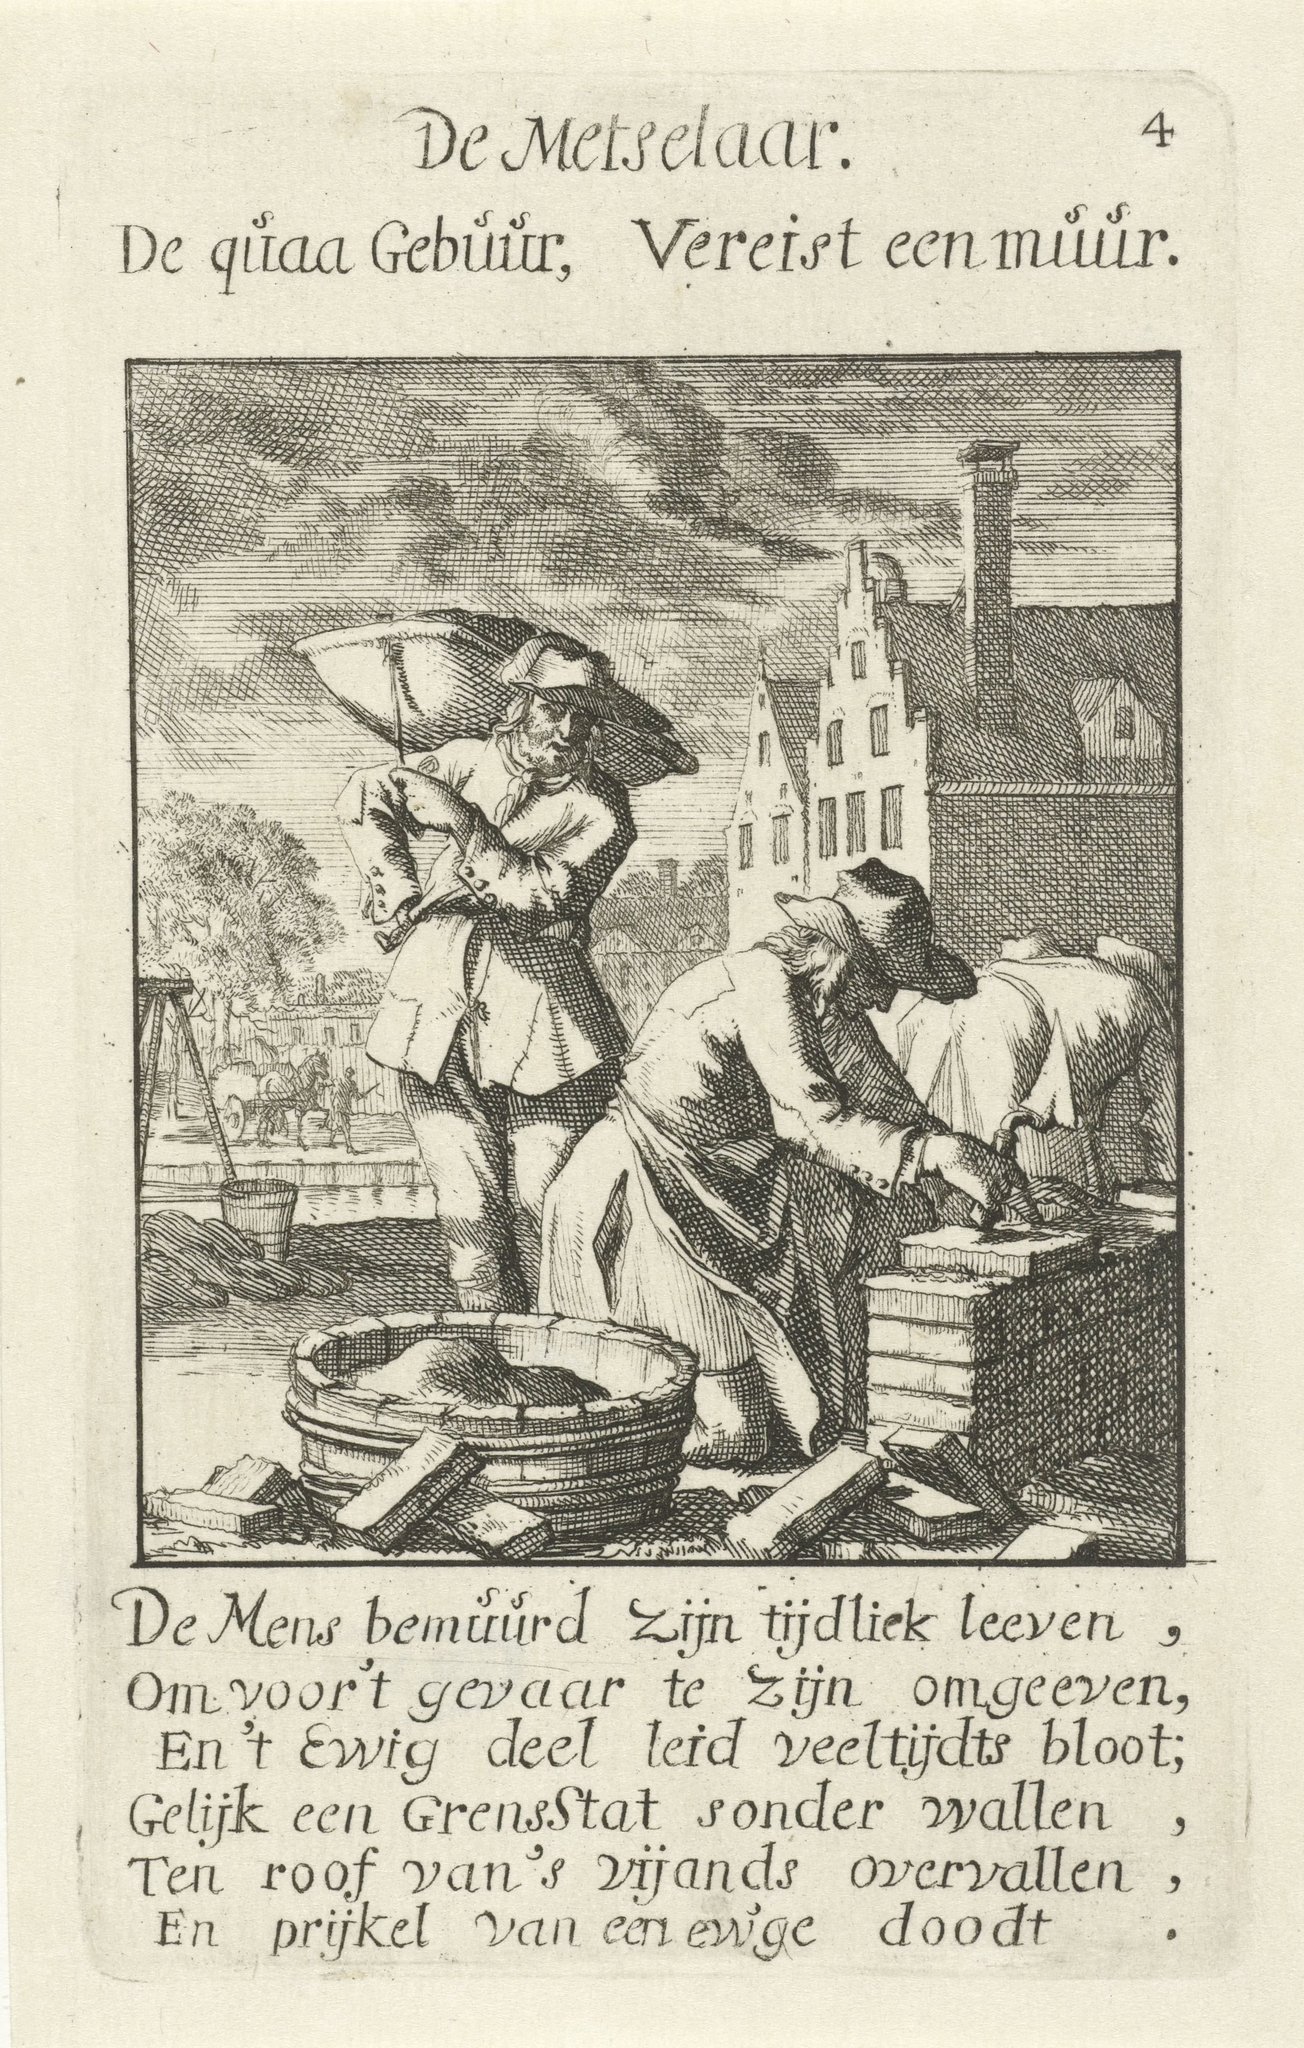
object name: print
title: De Metselaar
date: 1694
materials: paper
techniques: etching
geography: amsterdam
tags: handicrafts, craftsman at work, mason at work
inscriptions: collector's mark: Lugt 2228, collector's mark: Lugt 2760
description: Maakt deel uit van de 100-delige serie beroepsprenten van Jan en Caspar Luyken, getiteld: Het menselyk bedryf. S.l.s.n., 1694 (eerste druk).